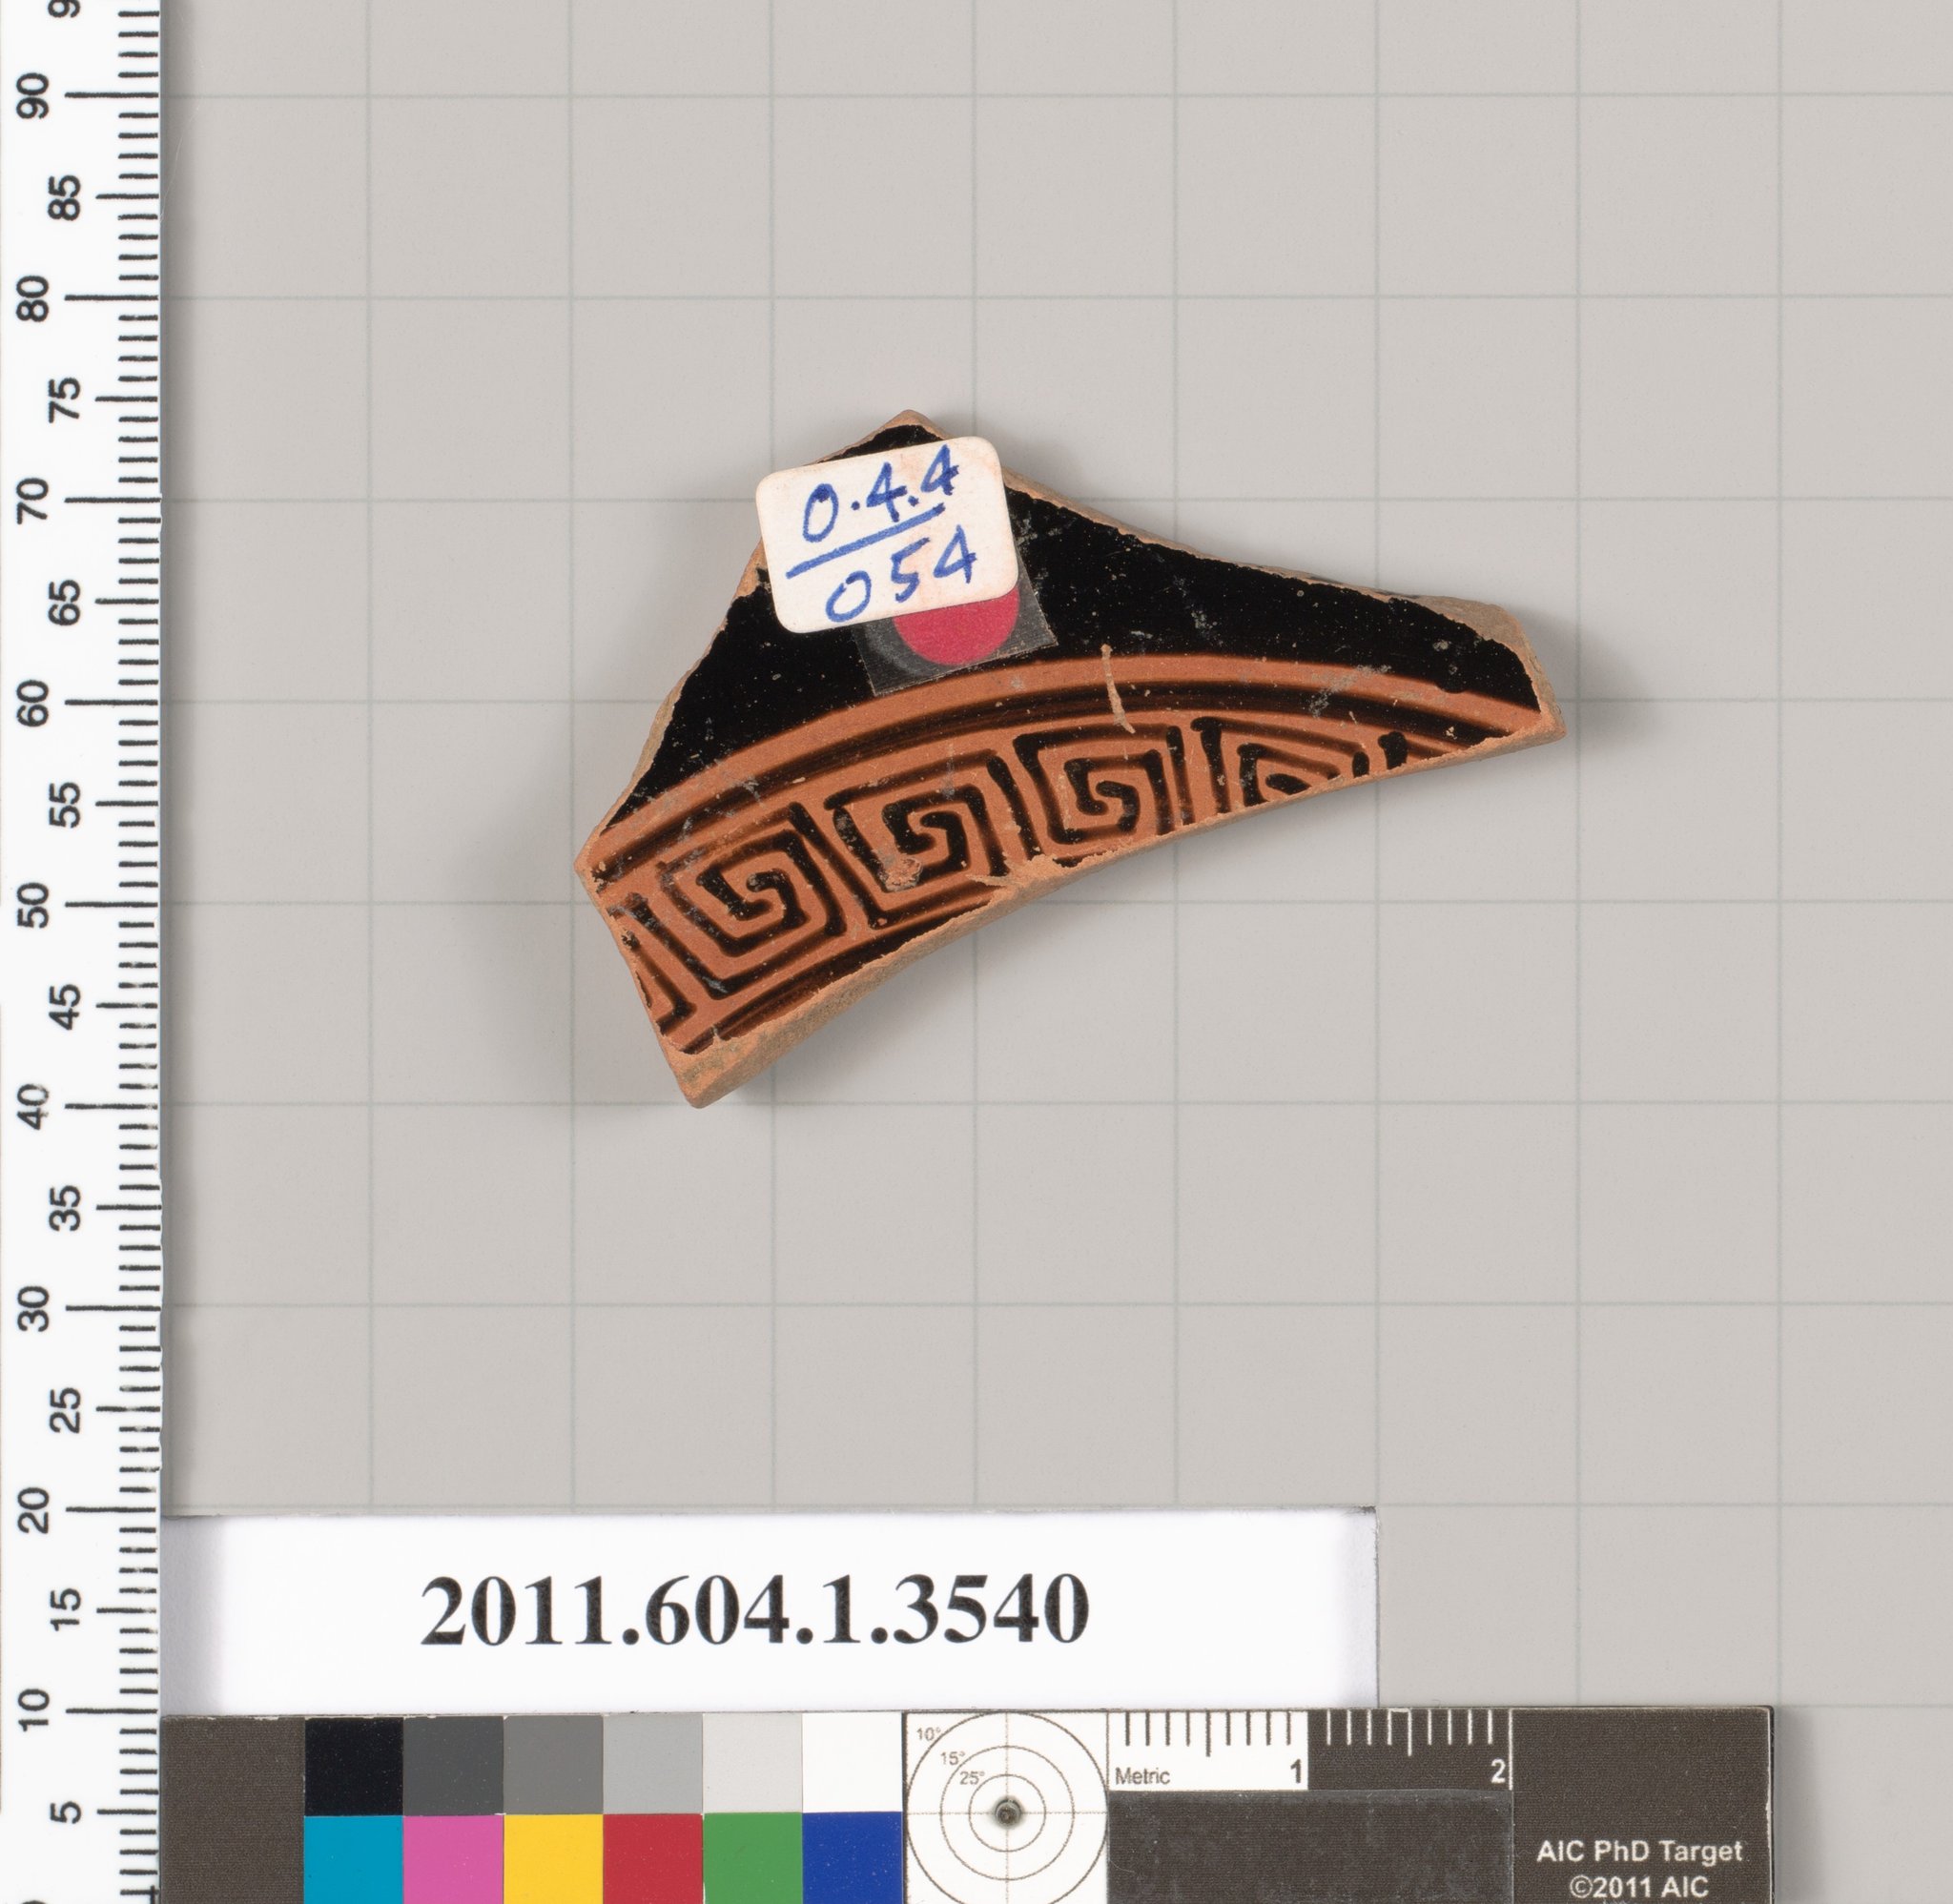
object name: kylix fragment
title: Terracotta fragment of a kylix (drinking cup)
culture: greek, attic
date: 475-451 BCE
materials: terracotta